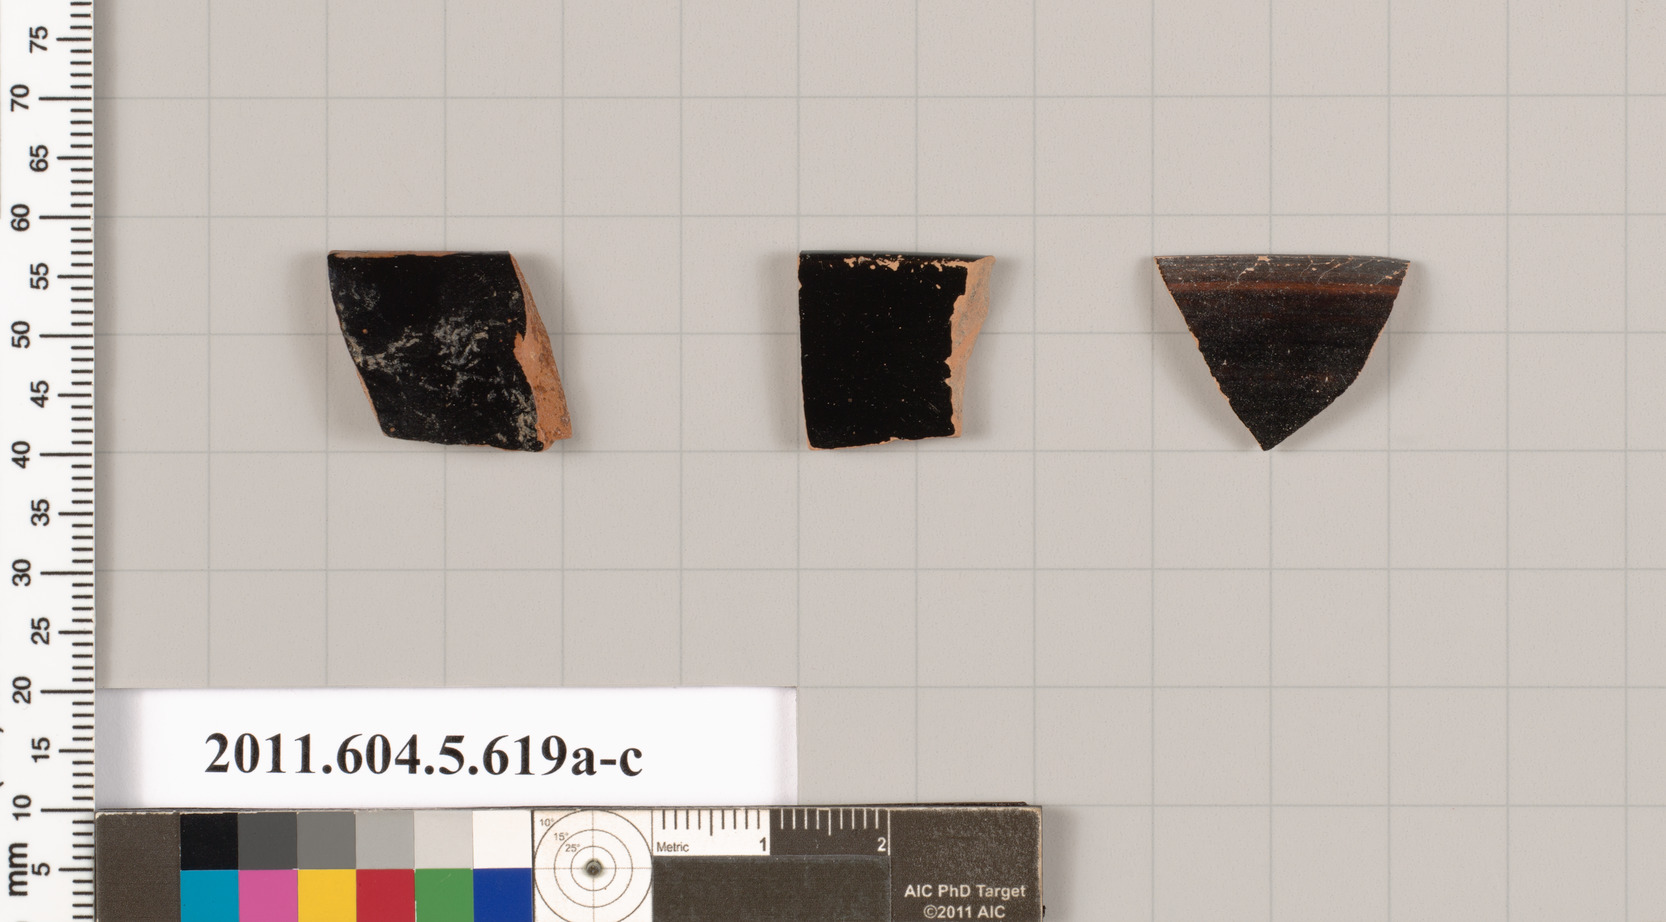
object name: kylix fragment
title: Terracotta rim fragments of kylikes (drinking cups)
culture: greek, attic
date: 600-401 BCE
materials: terracotta